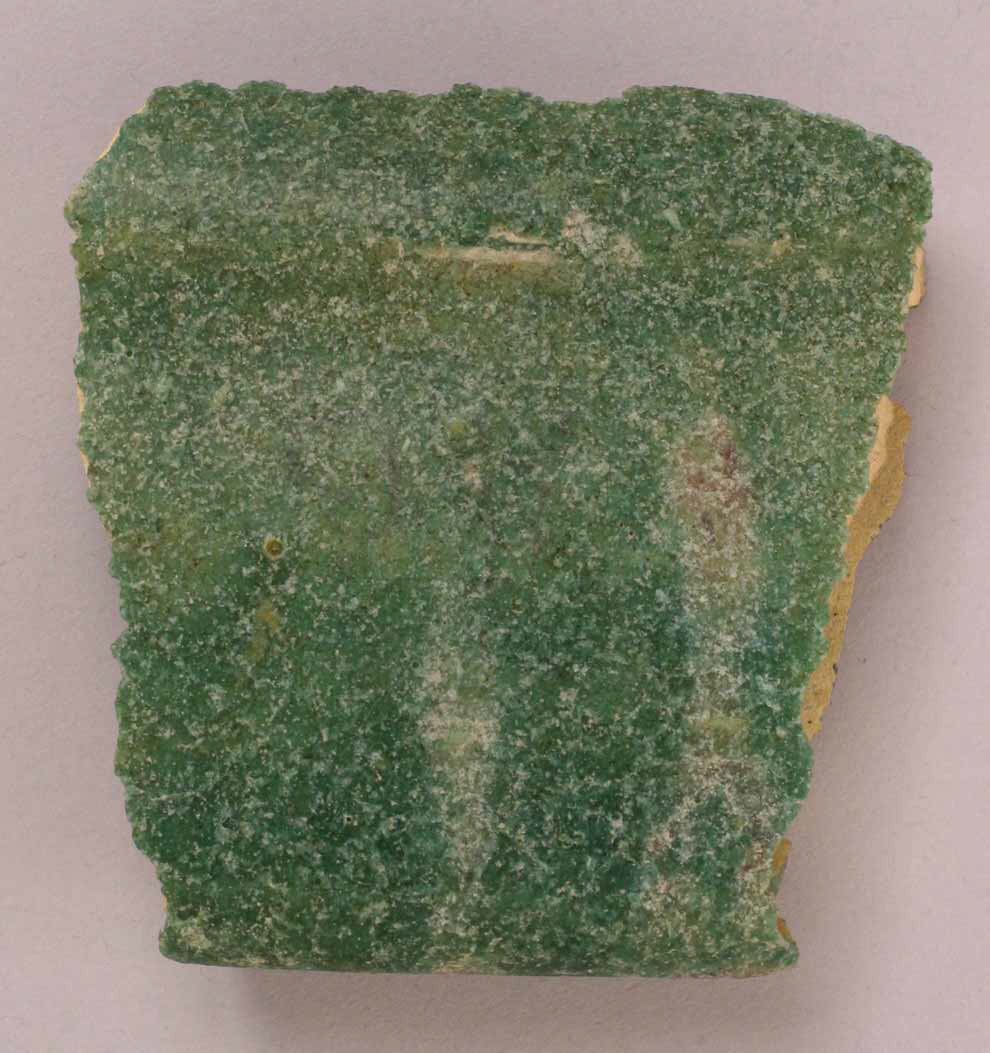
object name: fragment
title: Ceramic Fragment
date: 801-1000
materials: earthenware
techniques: glazing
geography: saudi arabia